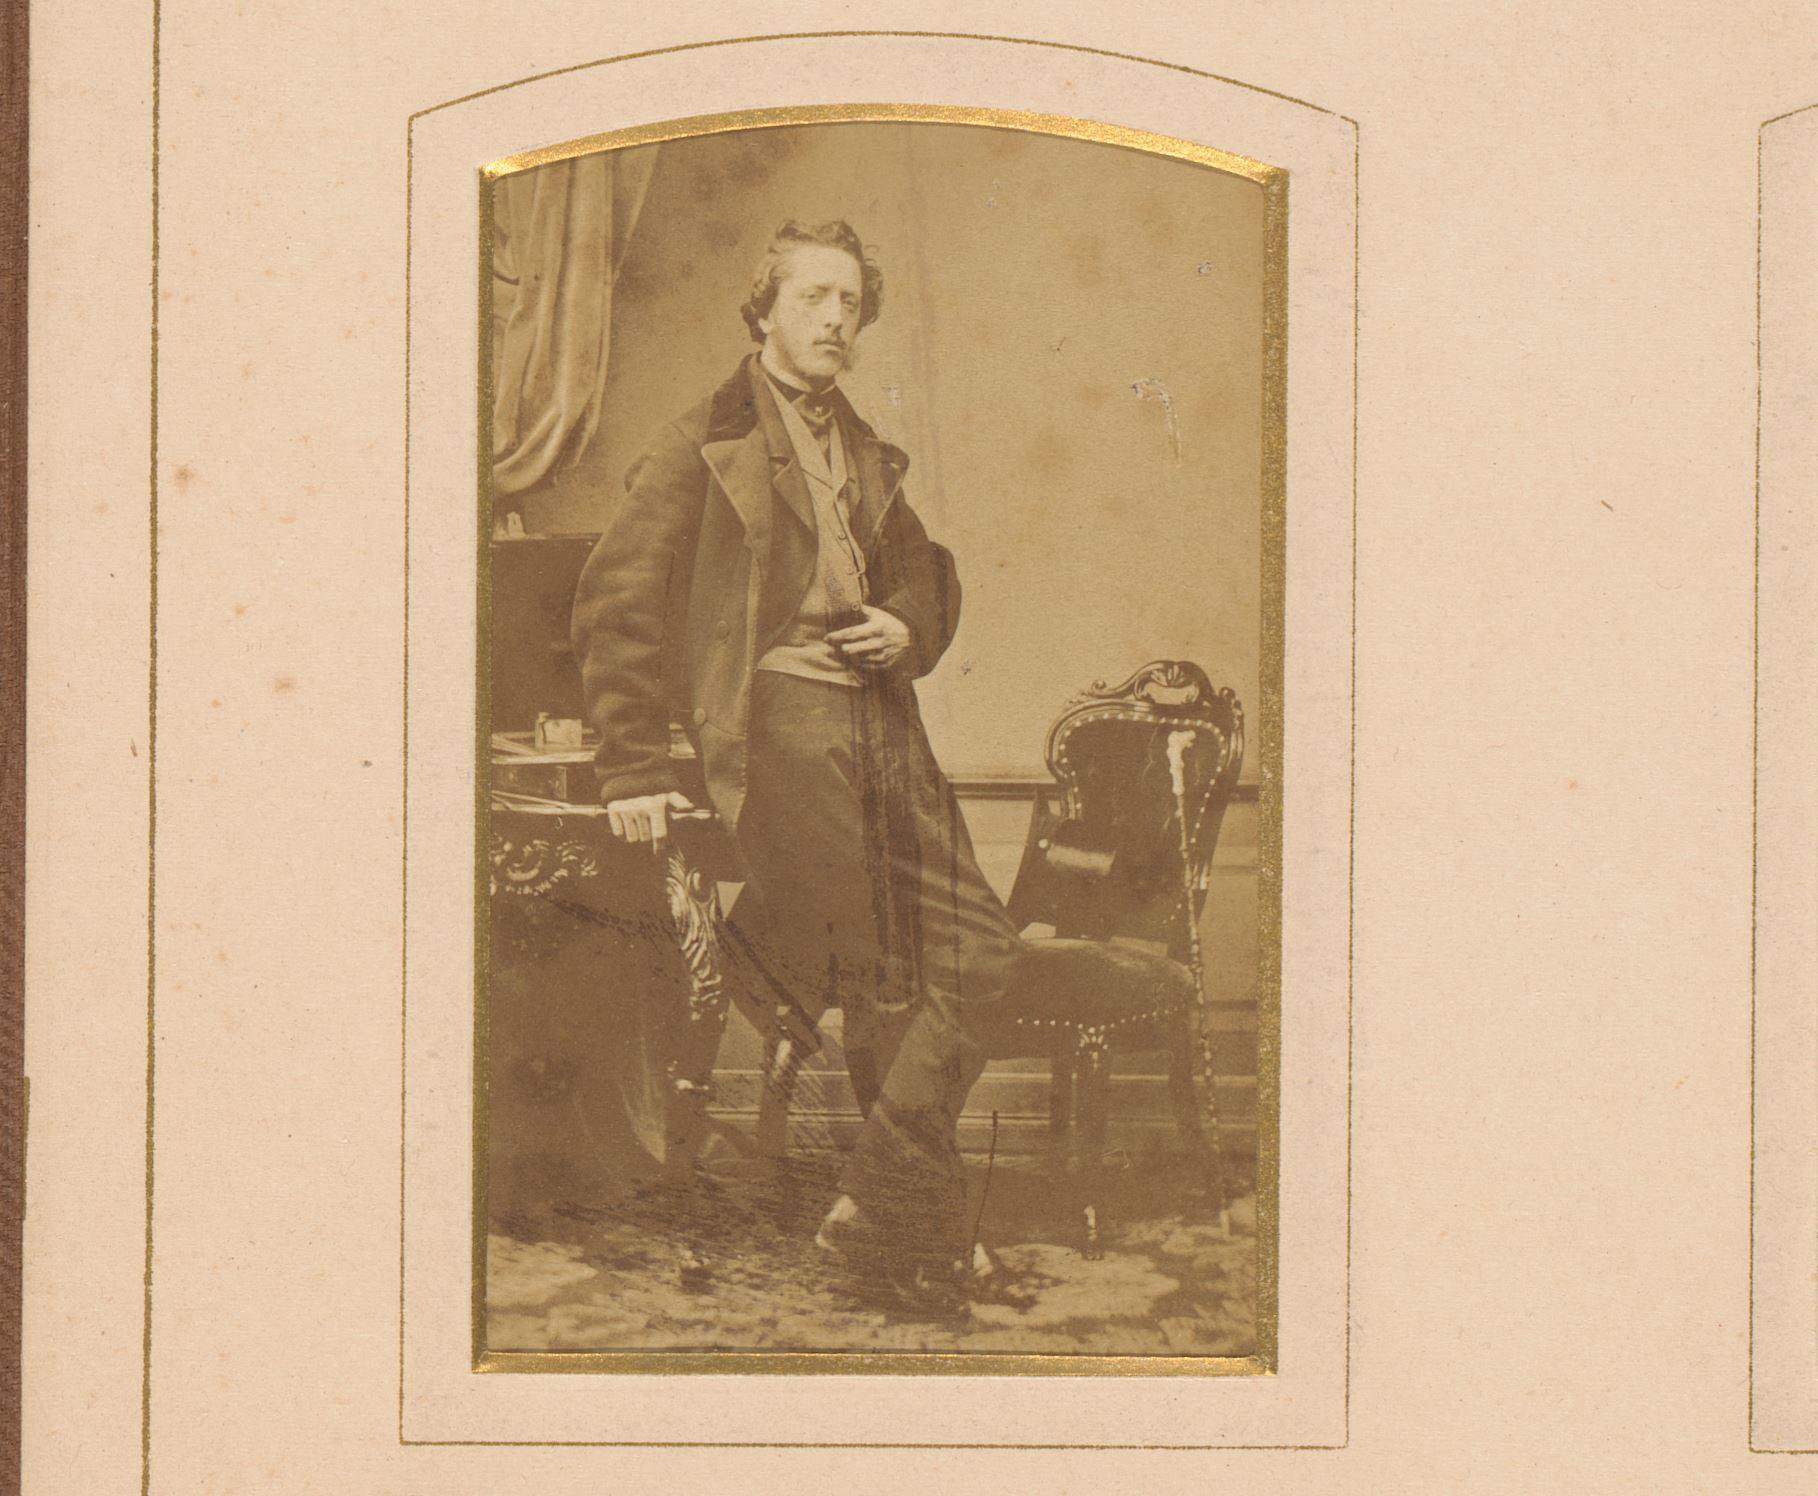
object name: carte de visite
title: Portret van een jonge man bij een bureau met schildersattributen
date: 1861-1865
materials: cardboard, photographic support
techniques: albumen print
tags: historical persons, youth, adolescent, tools, implements of painter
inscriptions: inscription: ‘PRONK & CONEN./ Plantage Middenlaan 132./ Vis à vis du Jardin Zoologique/ à / AMSTERDAM.’